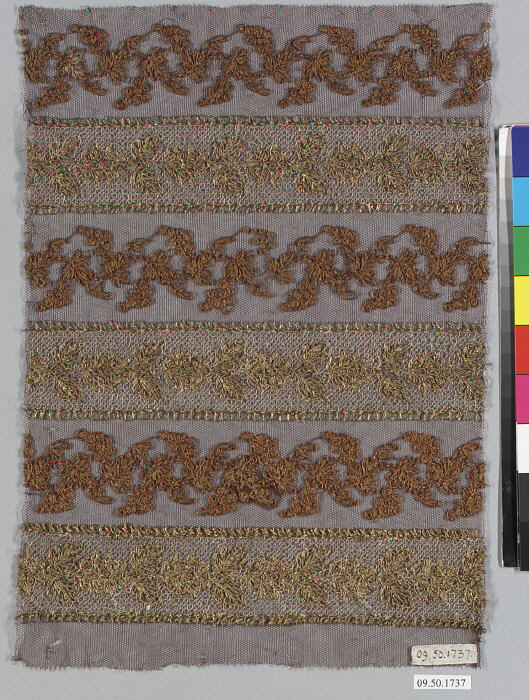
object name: fragment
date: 1801-1900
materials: lace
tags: leaves